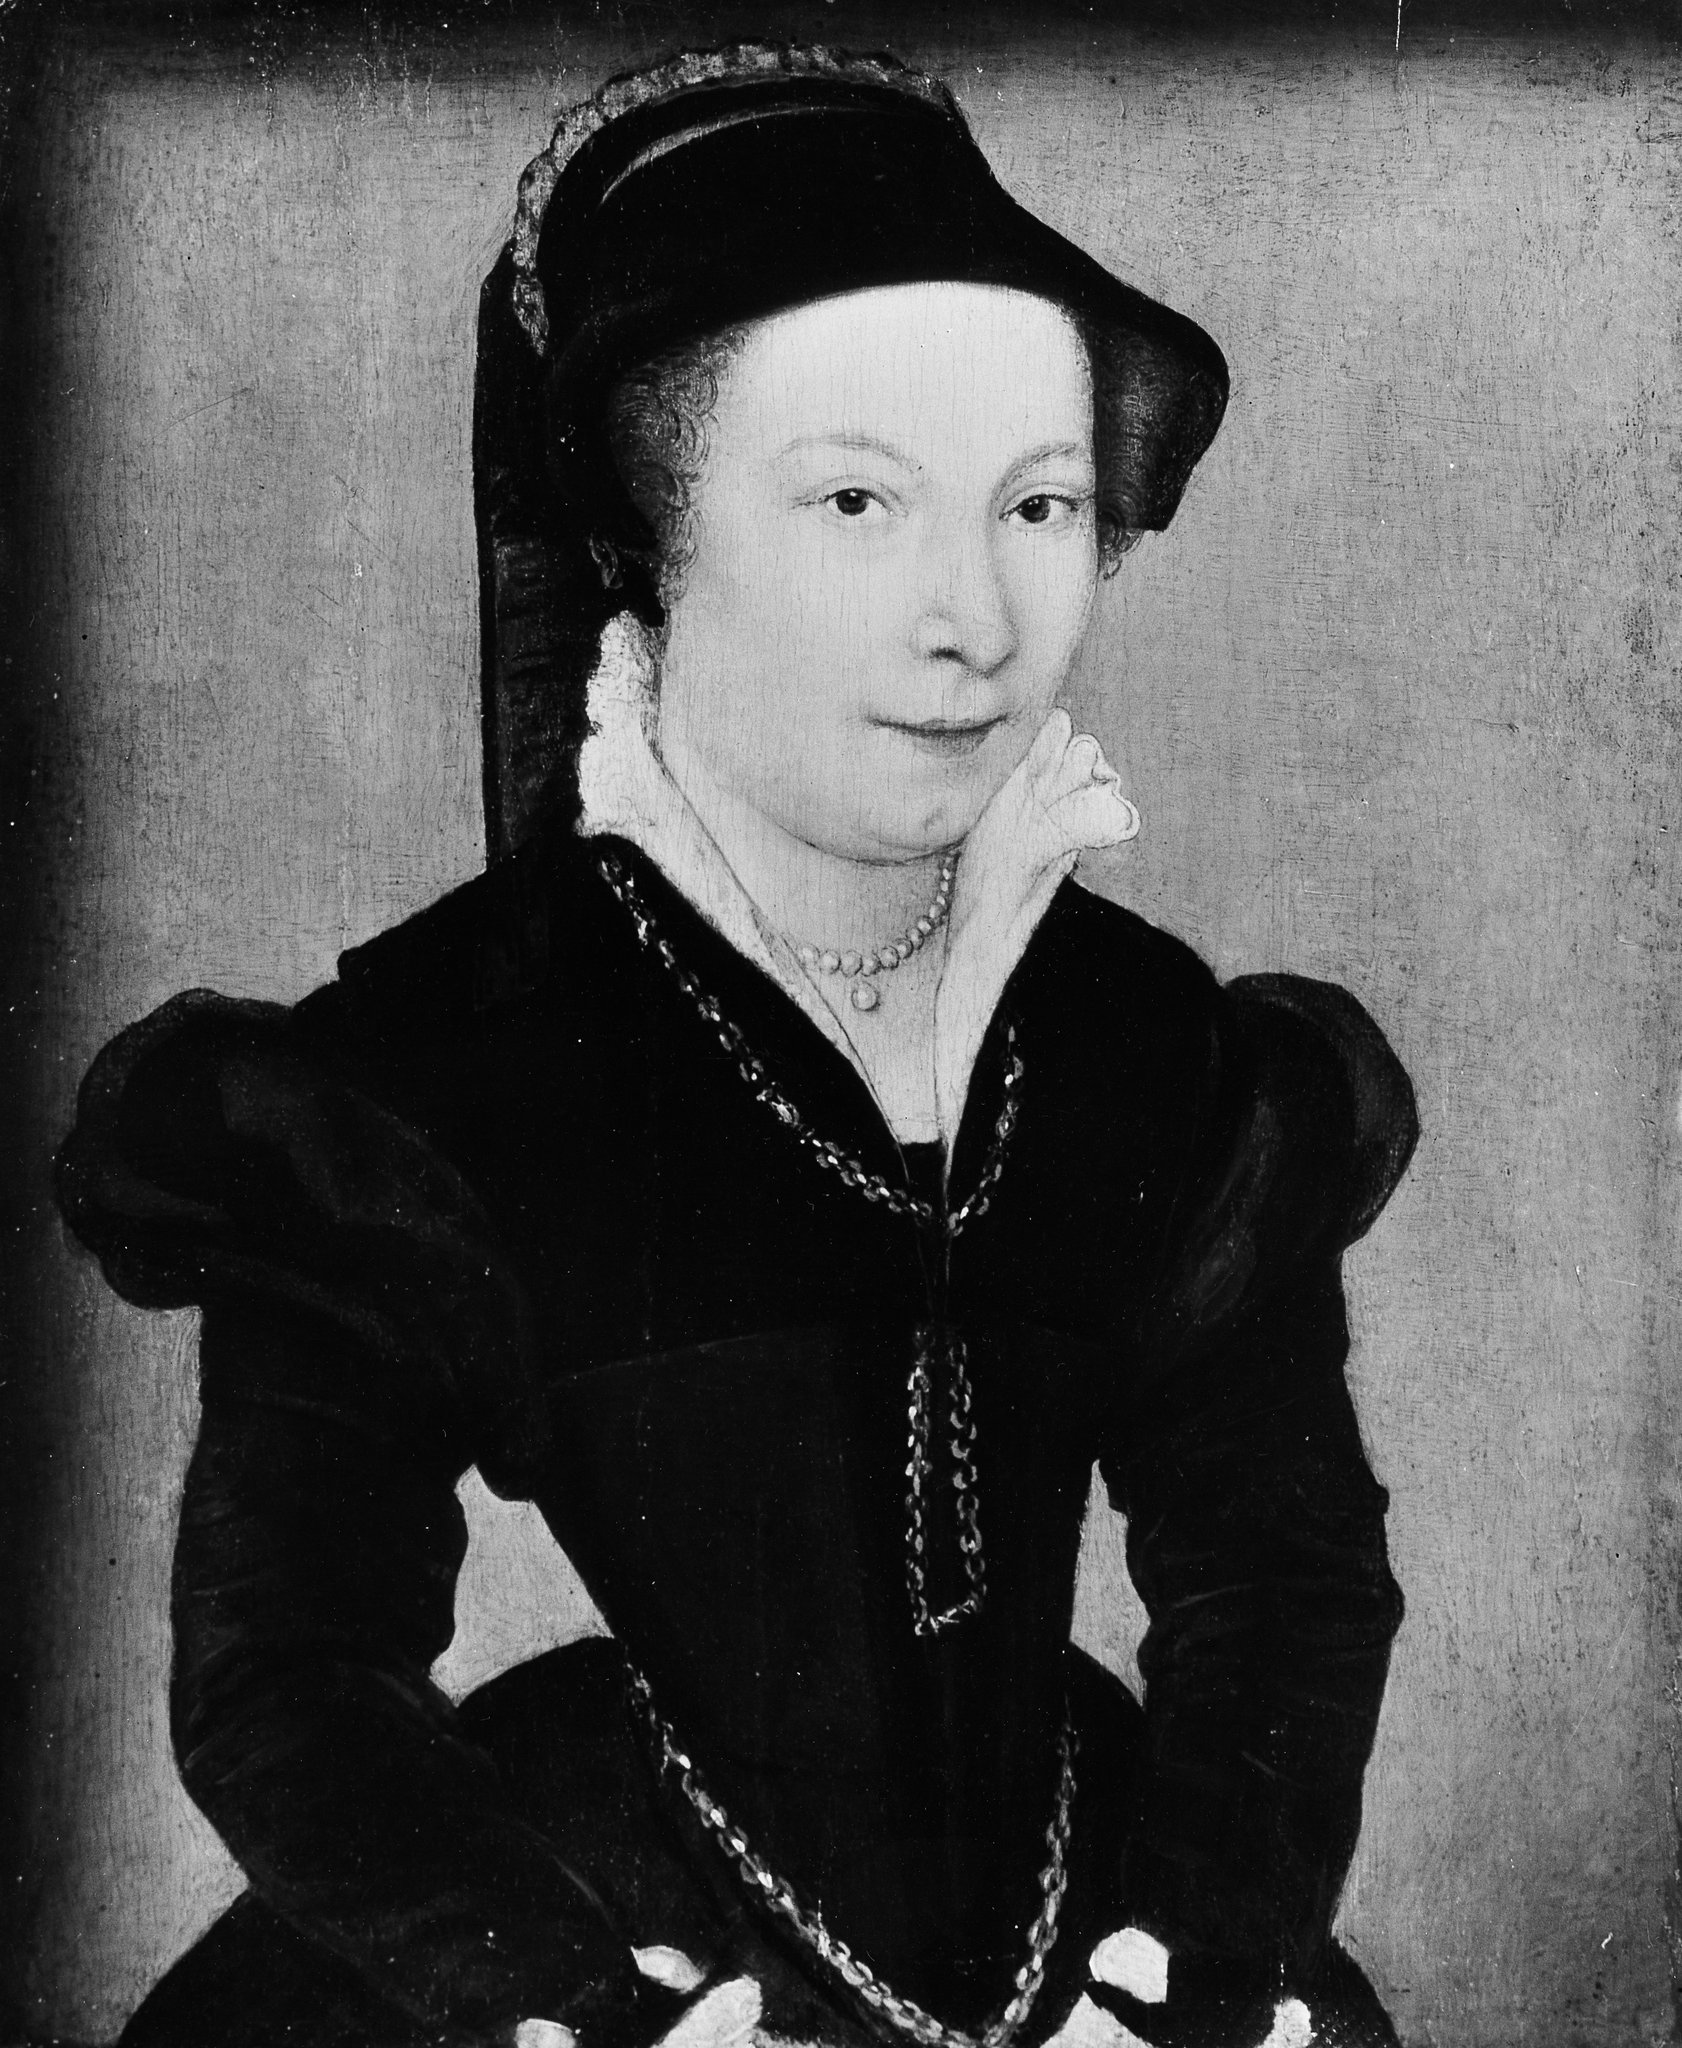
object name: painting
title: Portrait of a Widow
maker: corneille de lyon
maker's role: artist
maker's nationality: netherlandish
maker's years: 1533-1575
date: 1525-1549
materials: oil, wood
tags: portraits,women